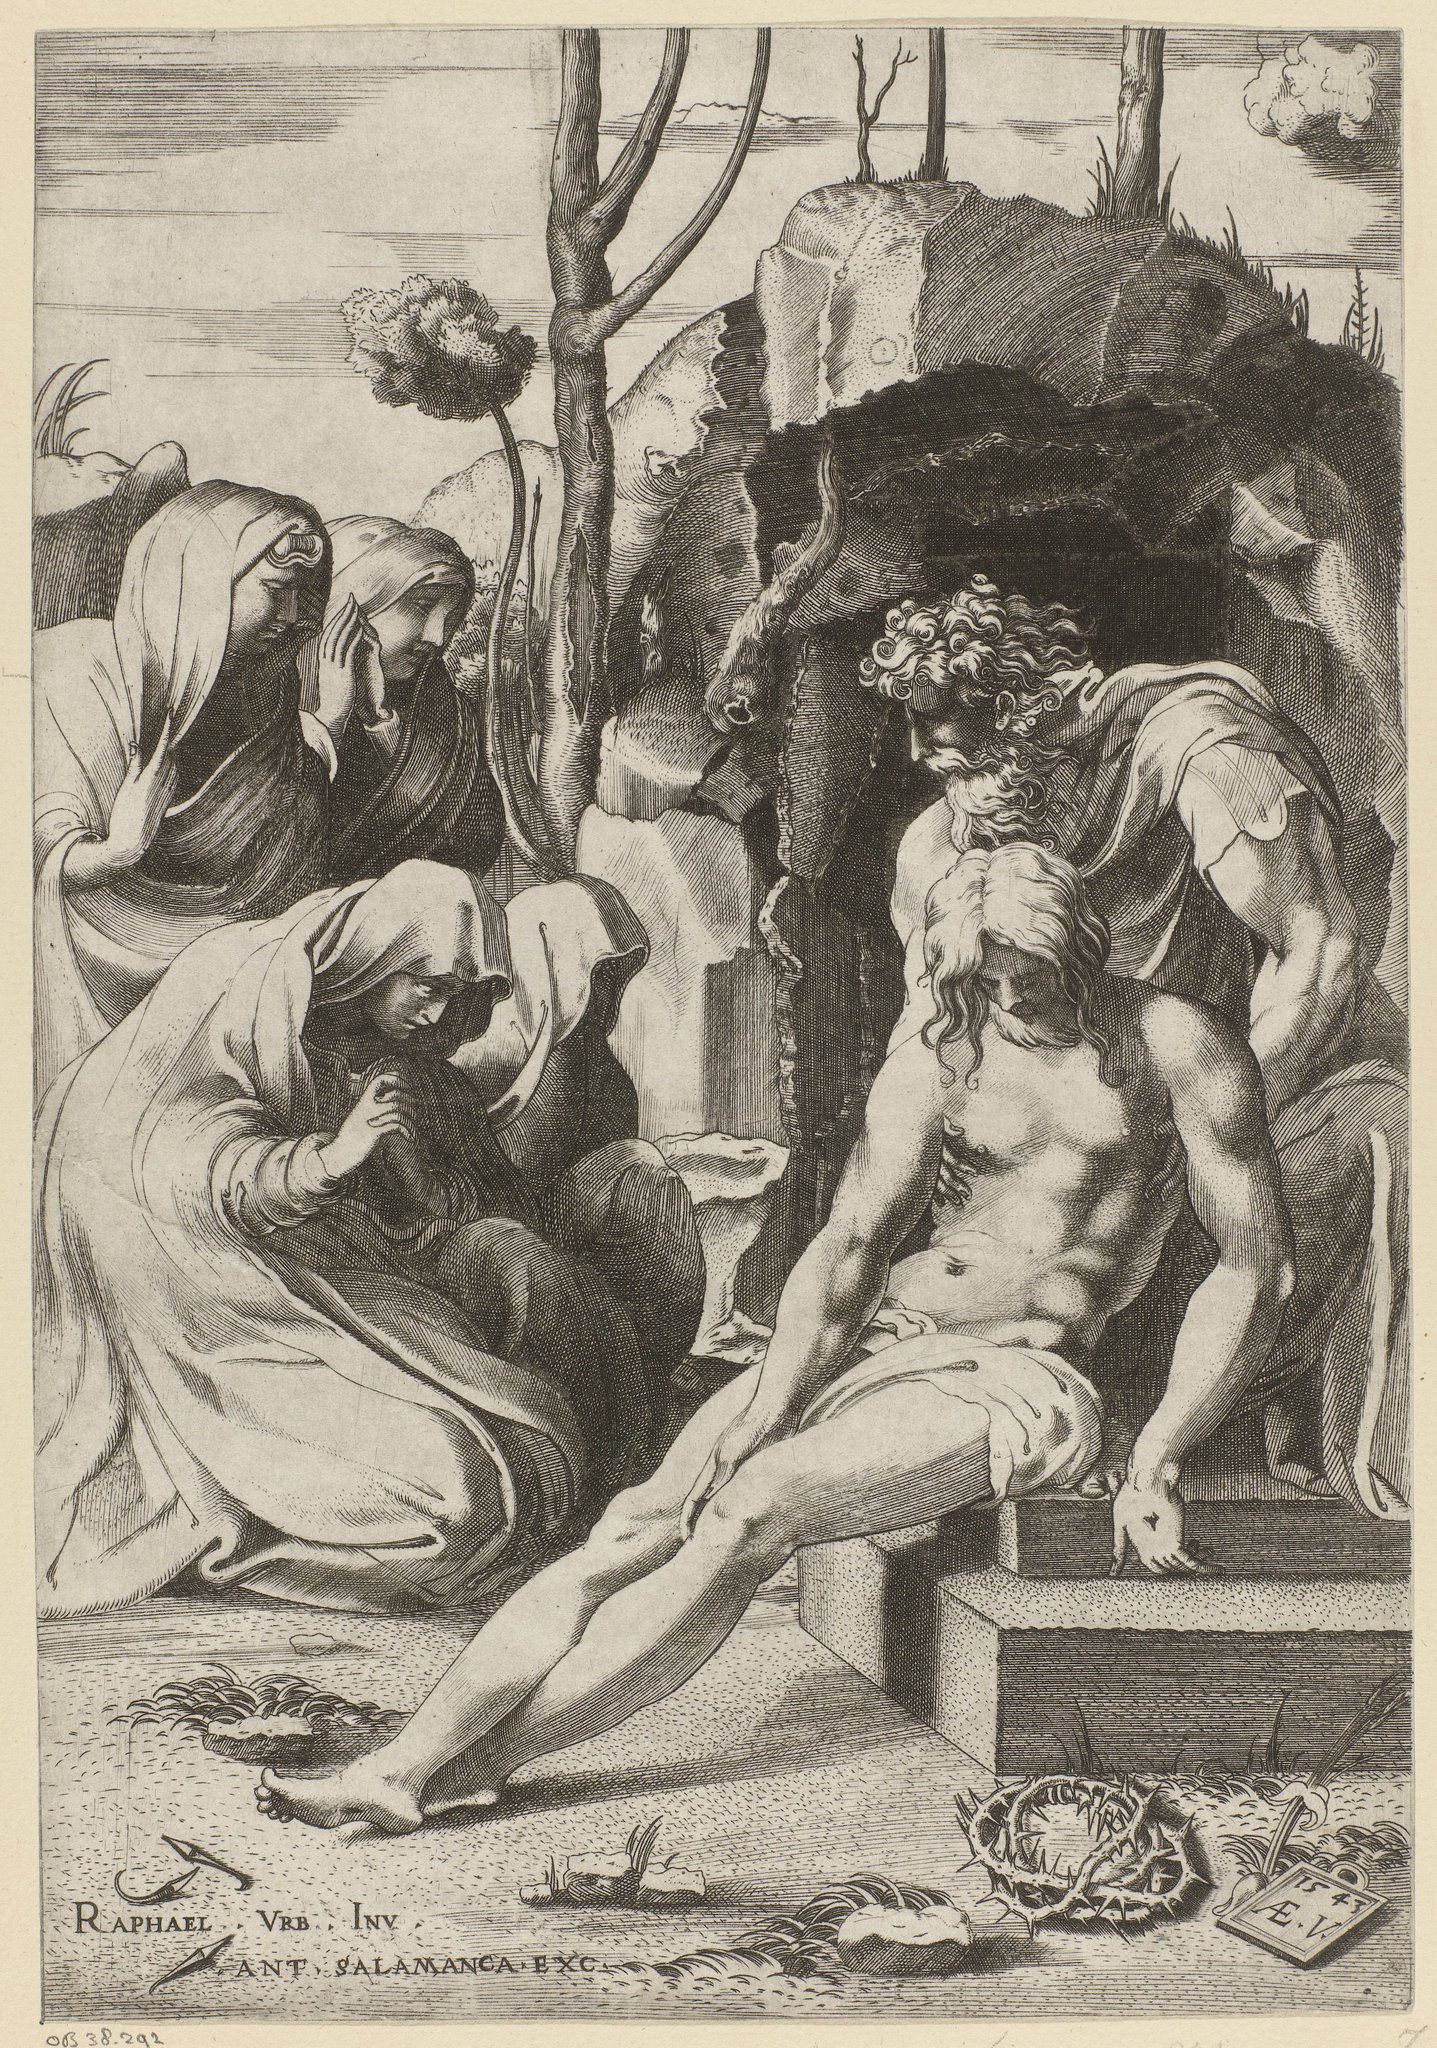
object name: print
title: Graflegging van Christus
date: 1543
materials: paper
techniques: engraving, etching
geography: italy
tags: christ's entombment (possibly by angels)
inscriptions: collector's mark: Lugt 240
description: Christus wordt door Jozef van Arimatea in het rotsgraf gelegd. Links de Maria's en op de voorgrond de passiewerktuigen.